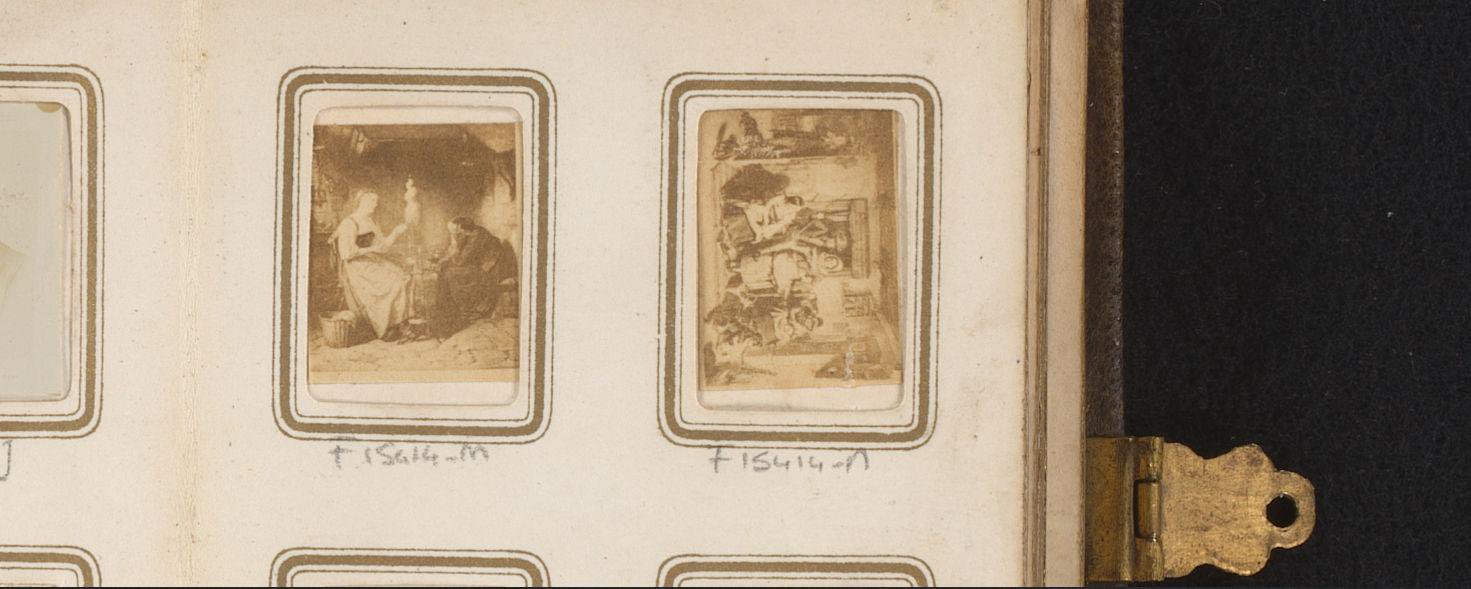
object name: album leaf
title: Fotoreproductie van een groep onbekende mensen voor een huis, op de voorgrond enkele honden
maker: Anonymous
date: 1851-1900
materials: paper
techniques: albumen print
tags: urban housing, dog